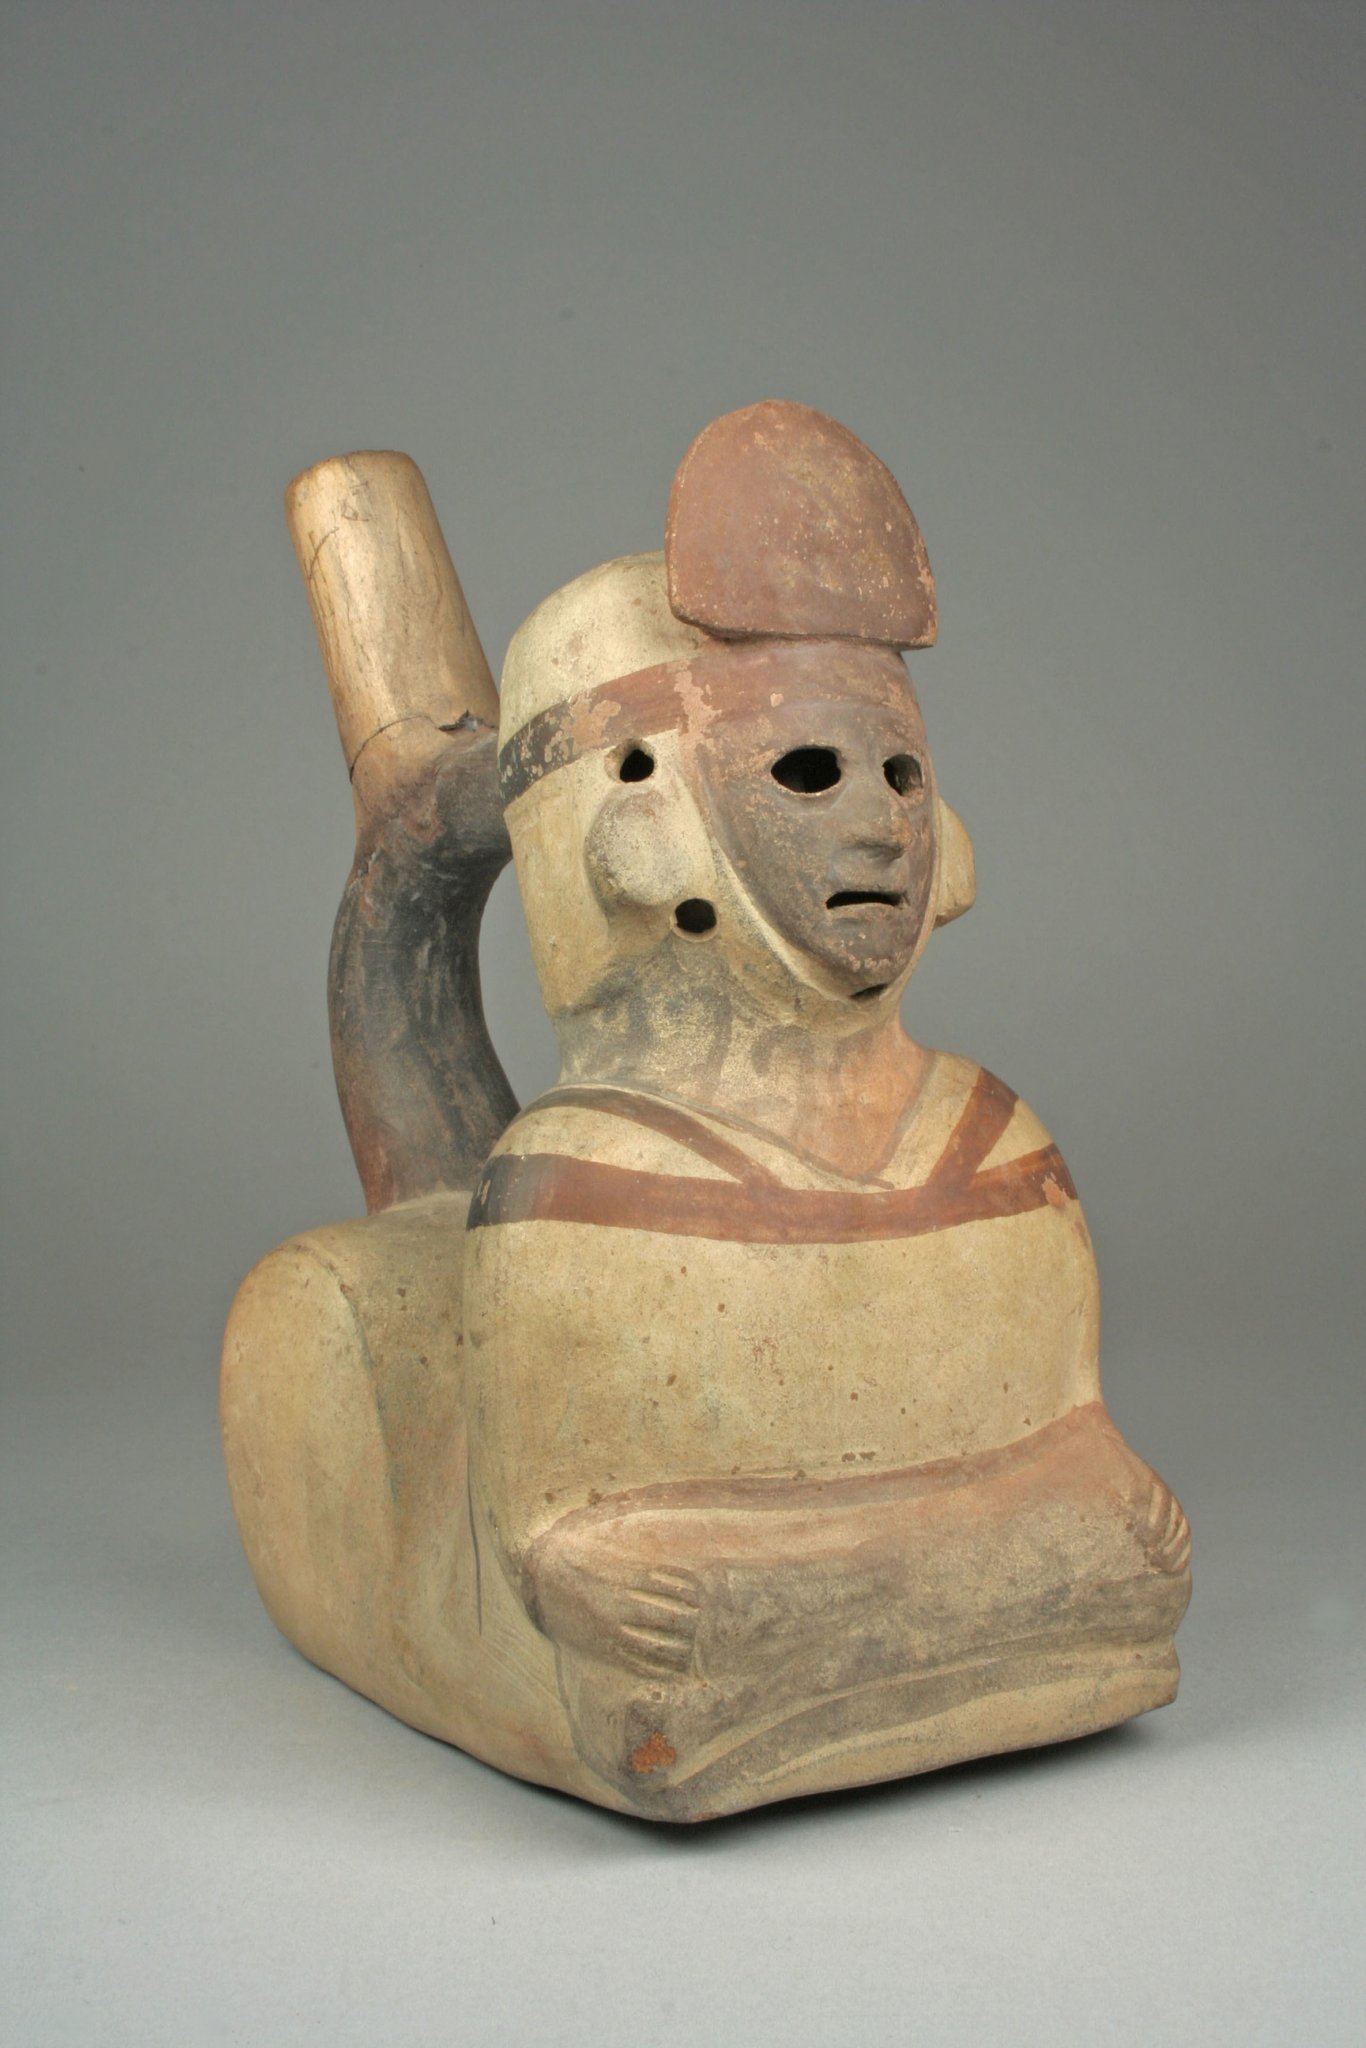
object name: bottle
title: Whistling Stirrup Spout Bottle with Figure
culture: moche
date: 401-700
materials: ceramic, pigment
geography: peru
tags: human figures,masks